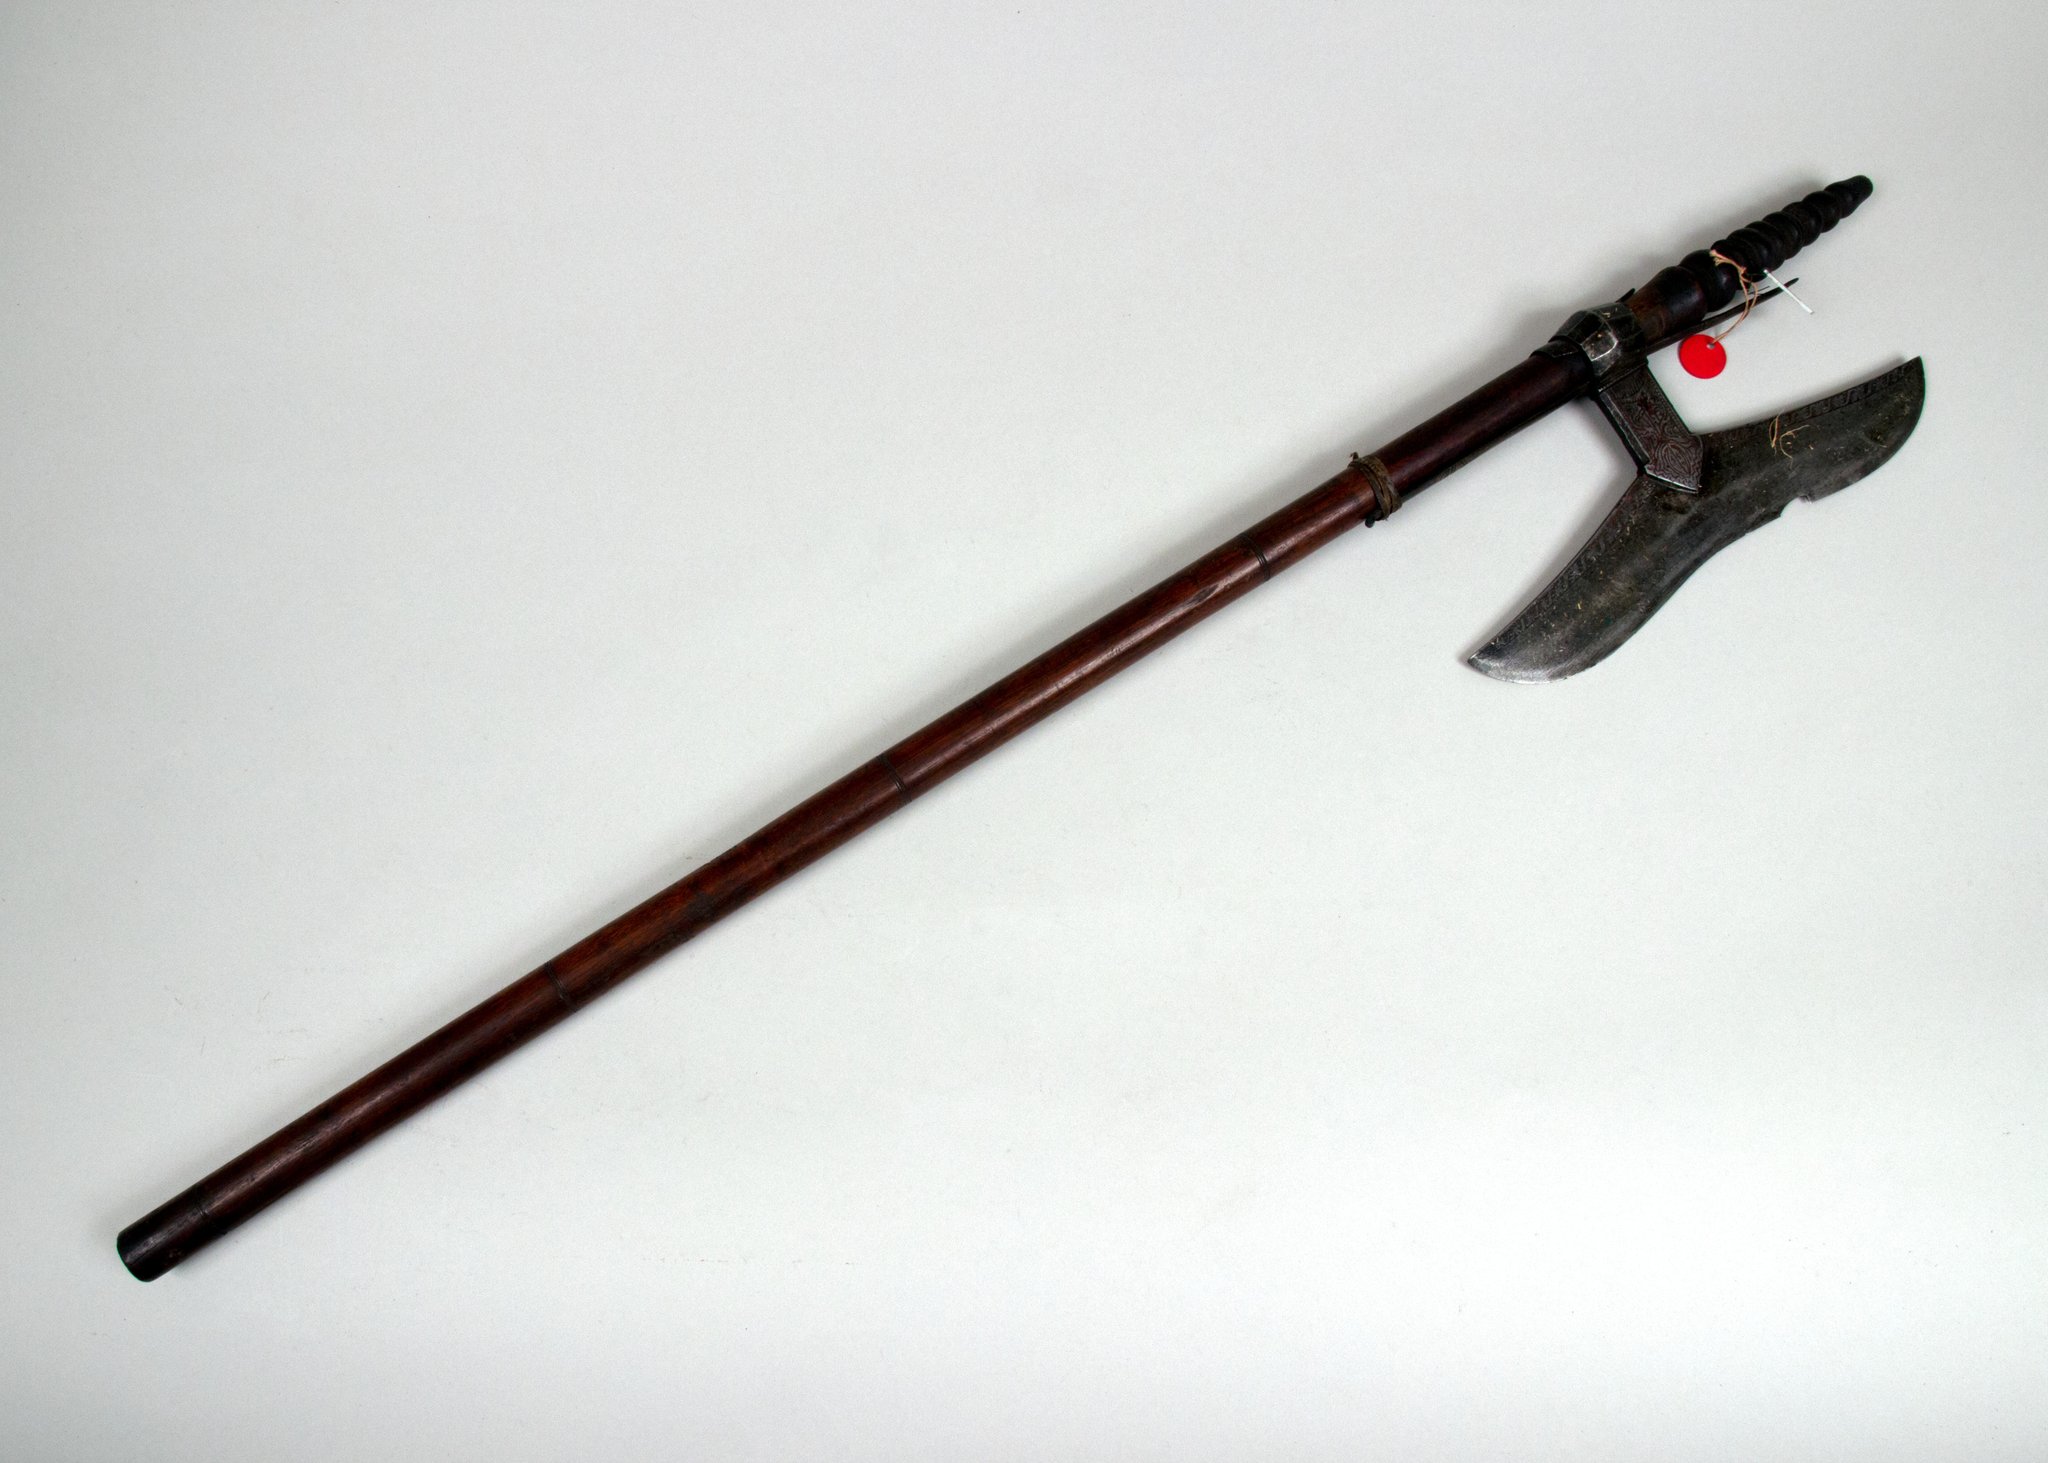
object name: axe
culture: indian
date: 1701-1900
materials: paste, steel, wood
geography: india